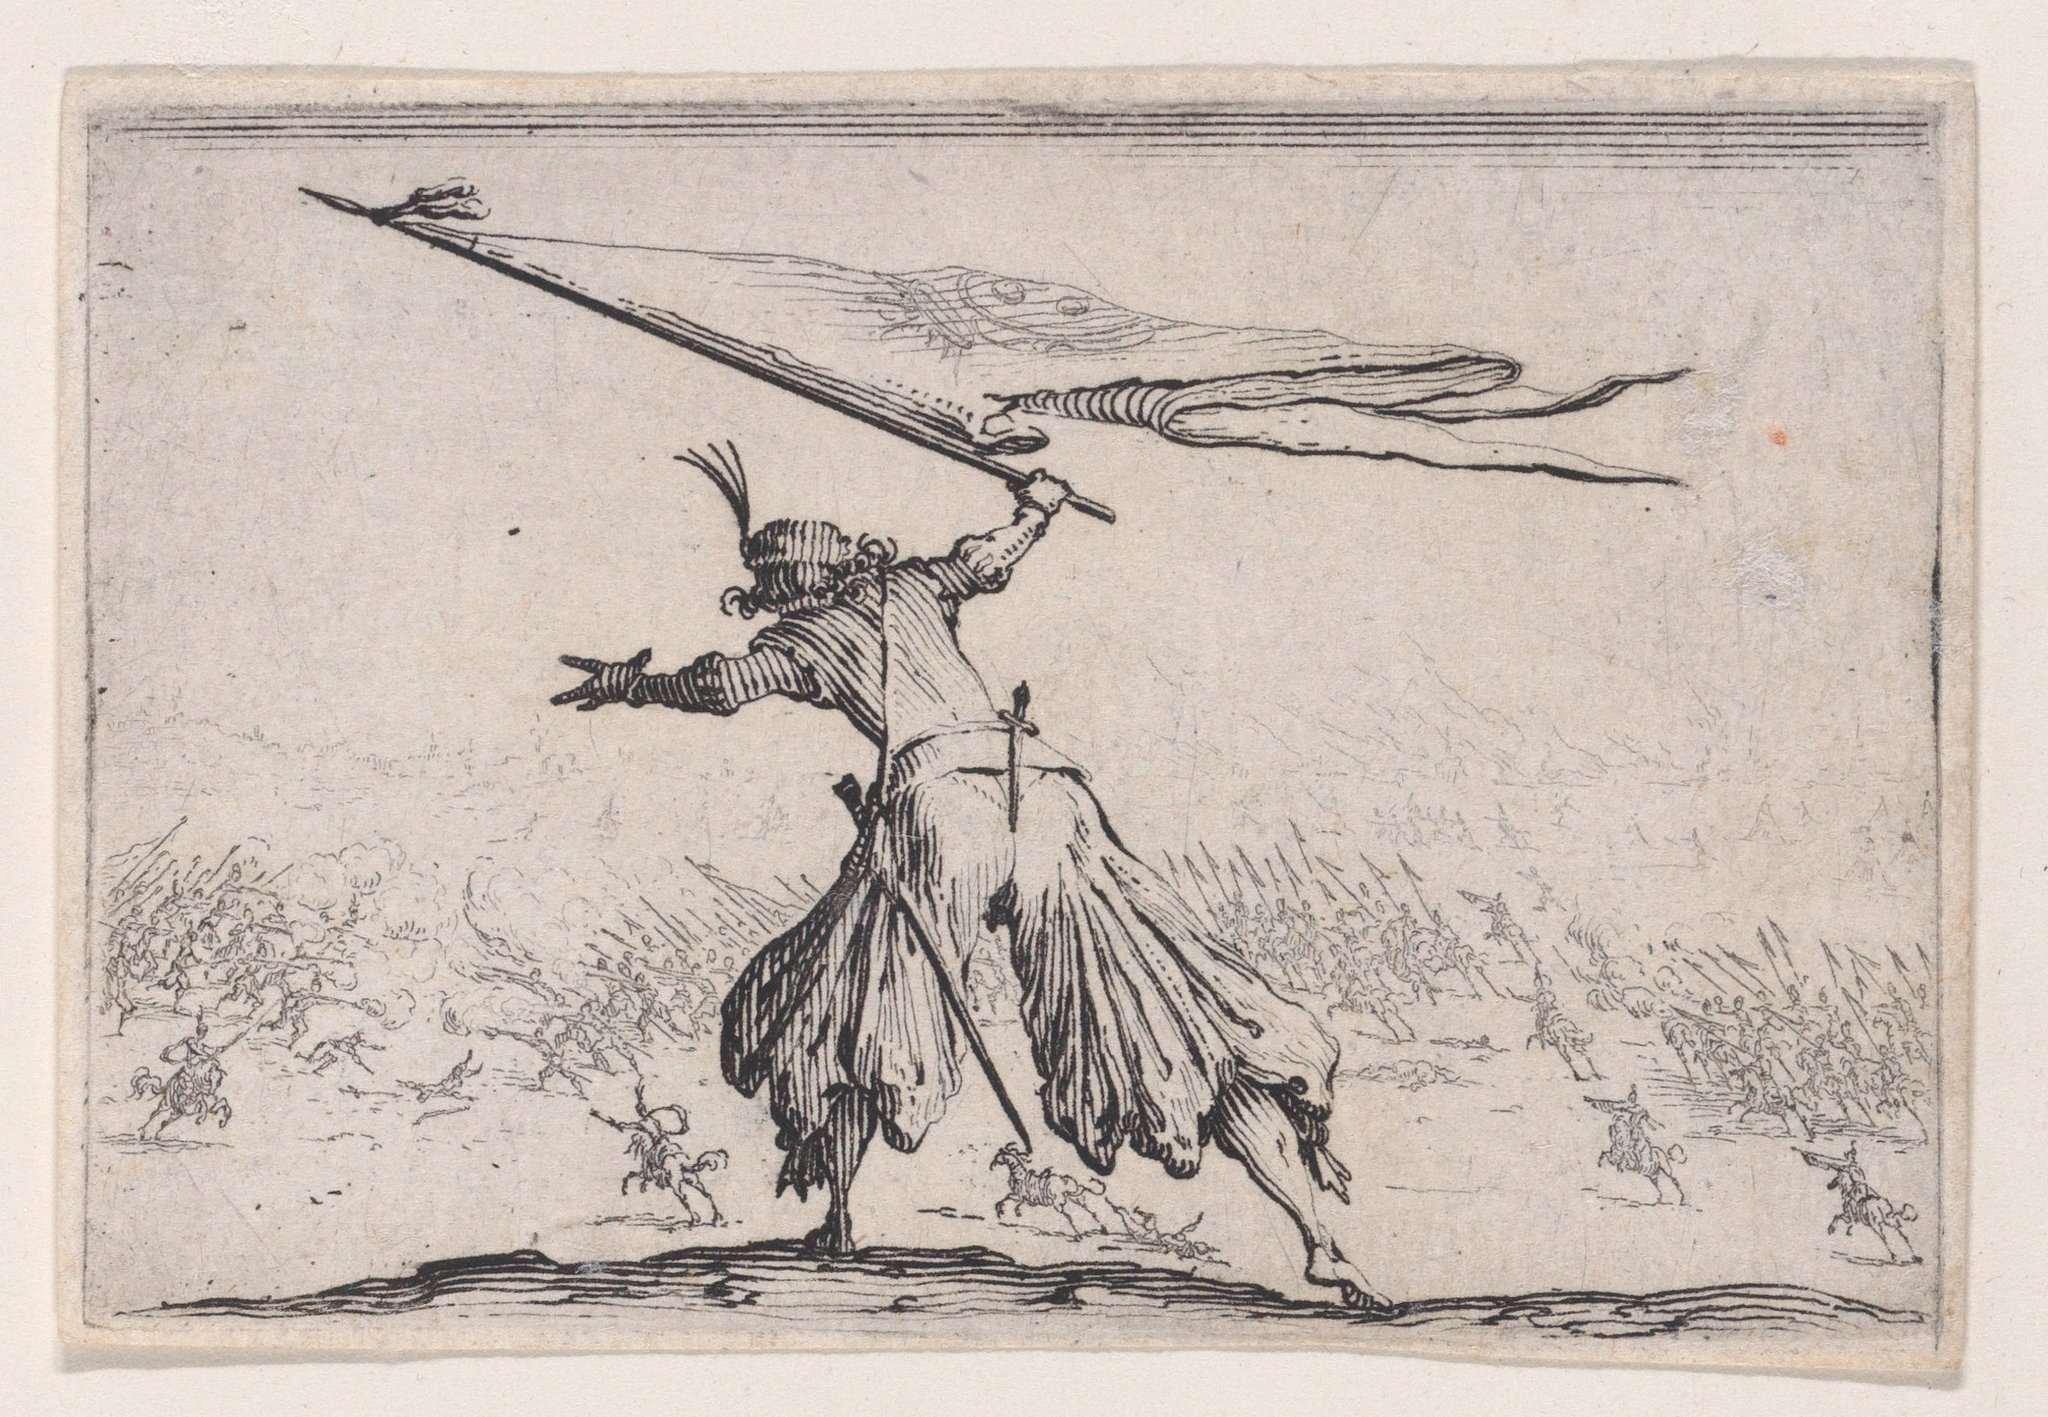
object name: print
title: Le Porte-Étendard (The Standard Bearer), from Les Caprices Series A, The Florence Set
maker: jacques callot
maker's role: artist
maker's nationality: french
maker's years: 1592-1635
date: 1617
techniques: etching